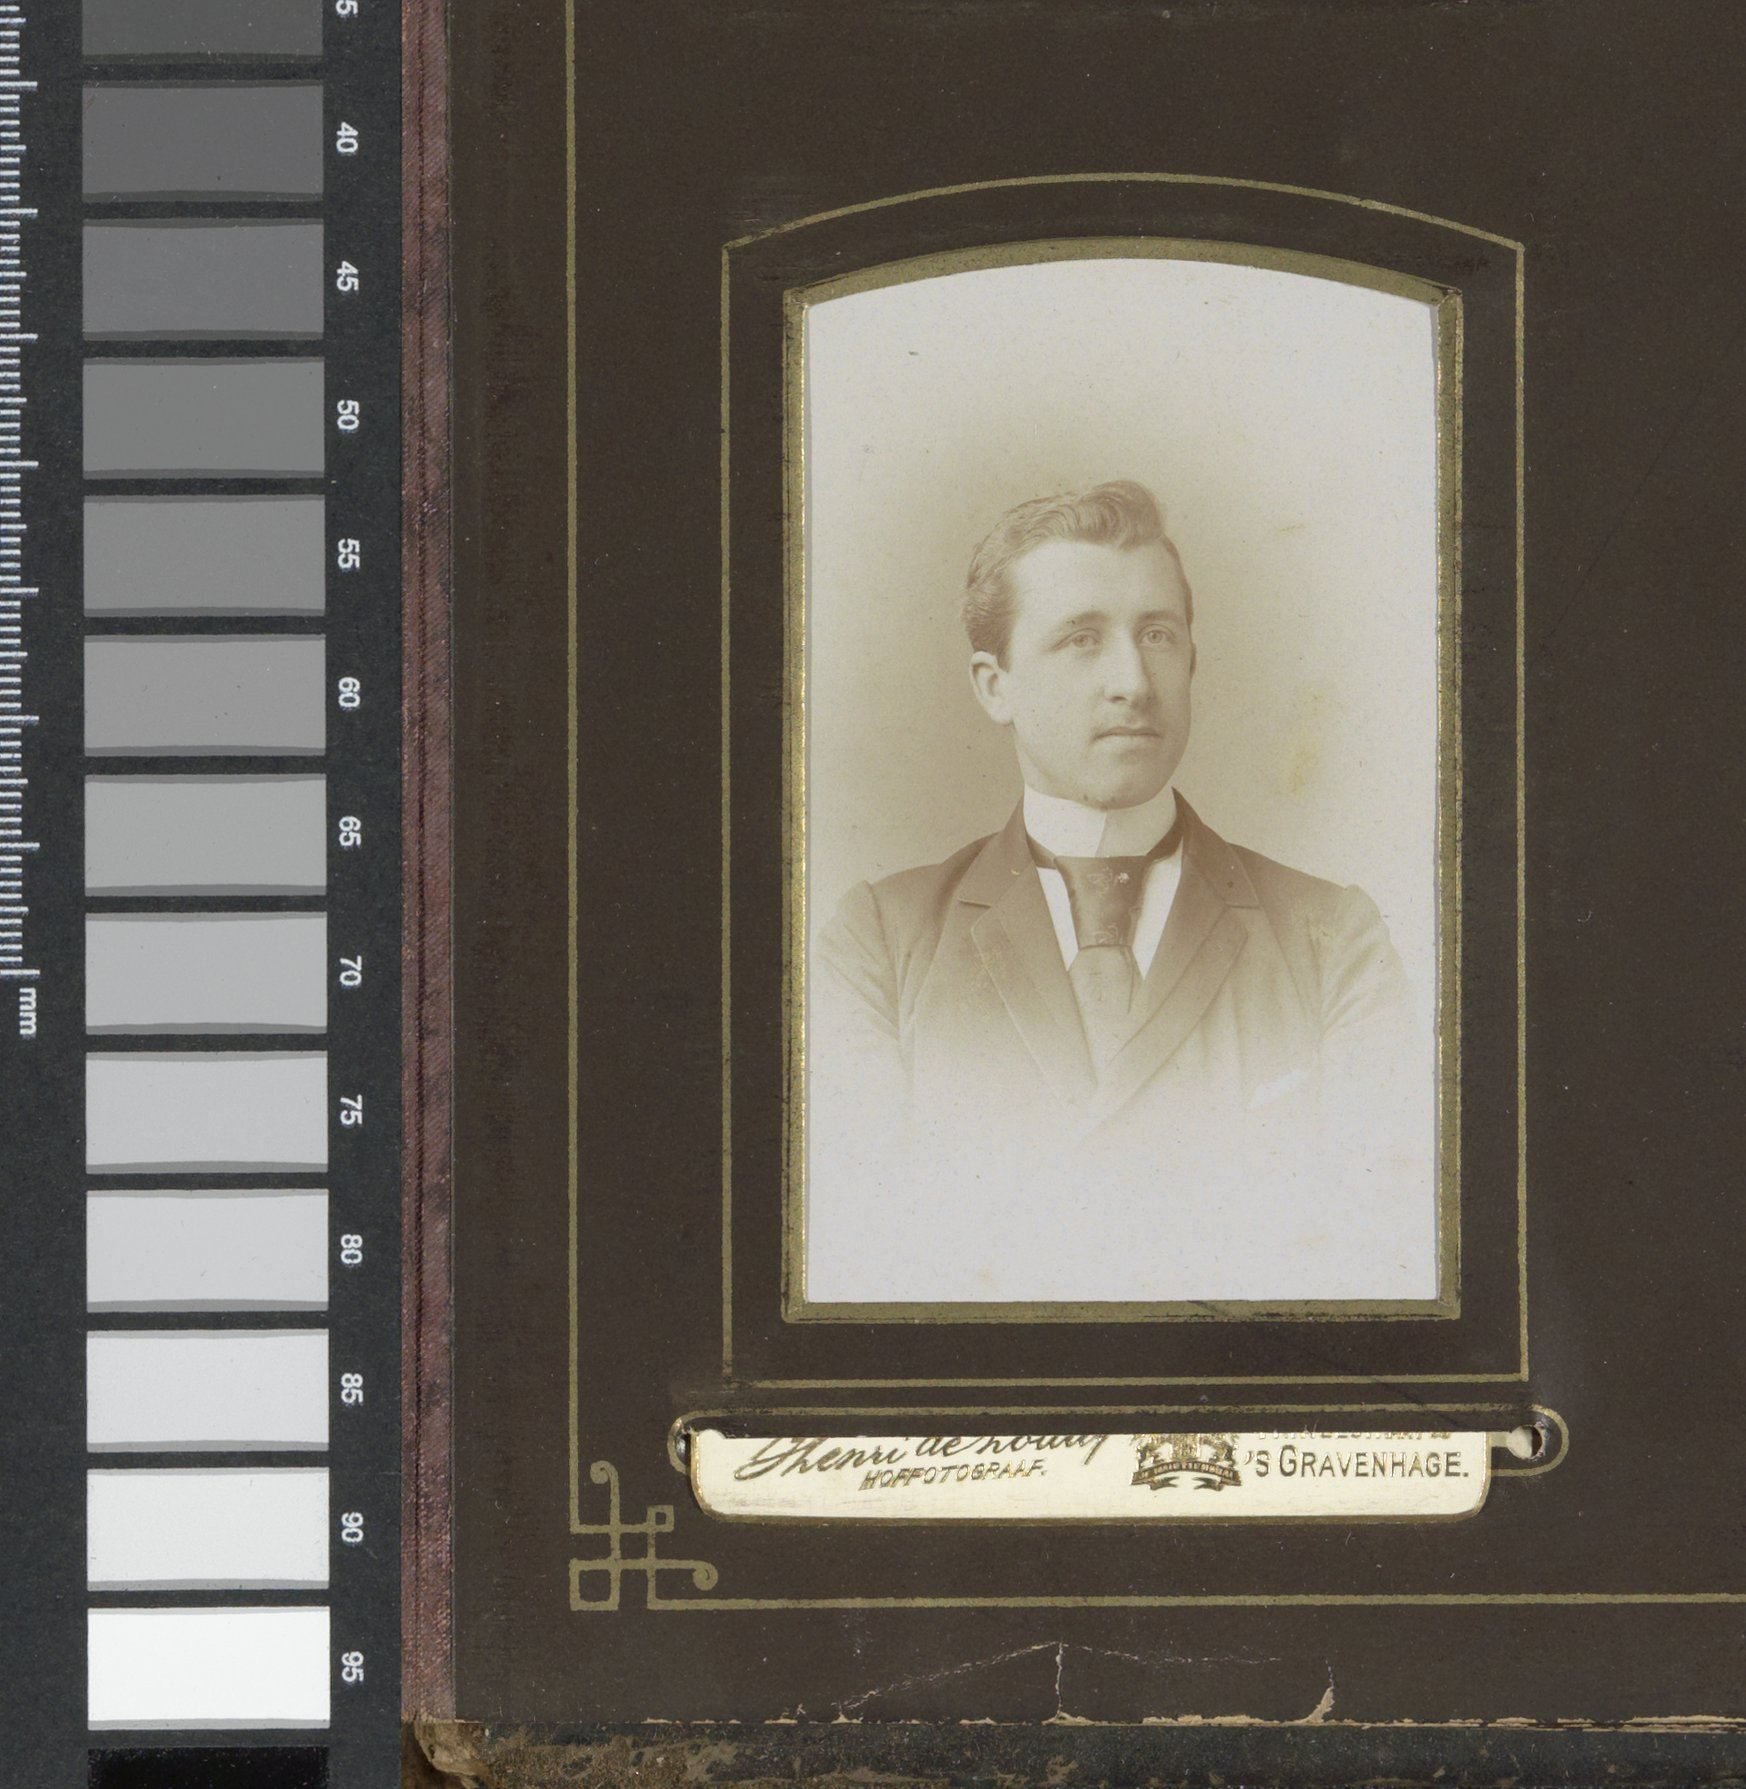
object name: photograph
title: Portret van een man met een stropdas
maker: henri de louw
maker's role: fotograaf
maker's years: 1851-1944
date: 1891-1910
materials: cardboard, paper, photographic support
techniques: collodion silver print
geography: the hague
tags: adult man, neck-gear ~ clothing, historical persons not known by name, the hague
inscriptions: address: ‘Prinsestraat 99 's Gravenhage.’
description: Onderdeel van Fotoalbum van de families Matthes, Doorman en Van Thiel.